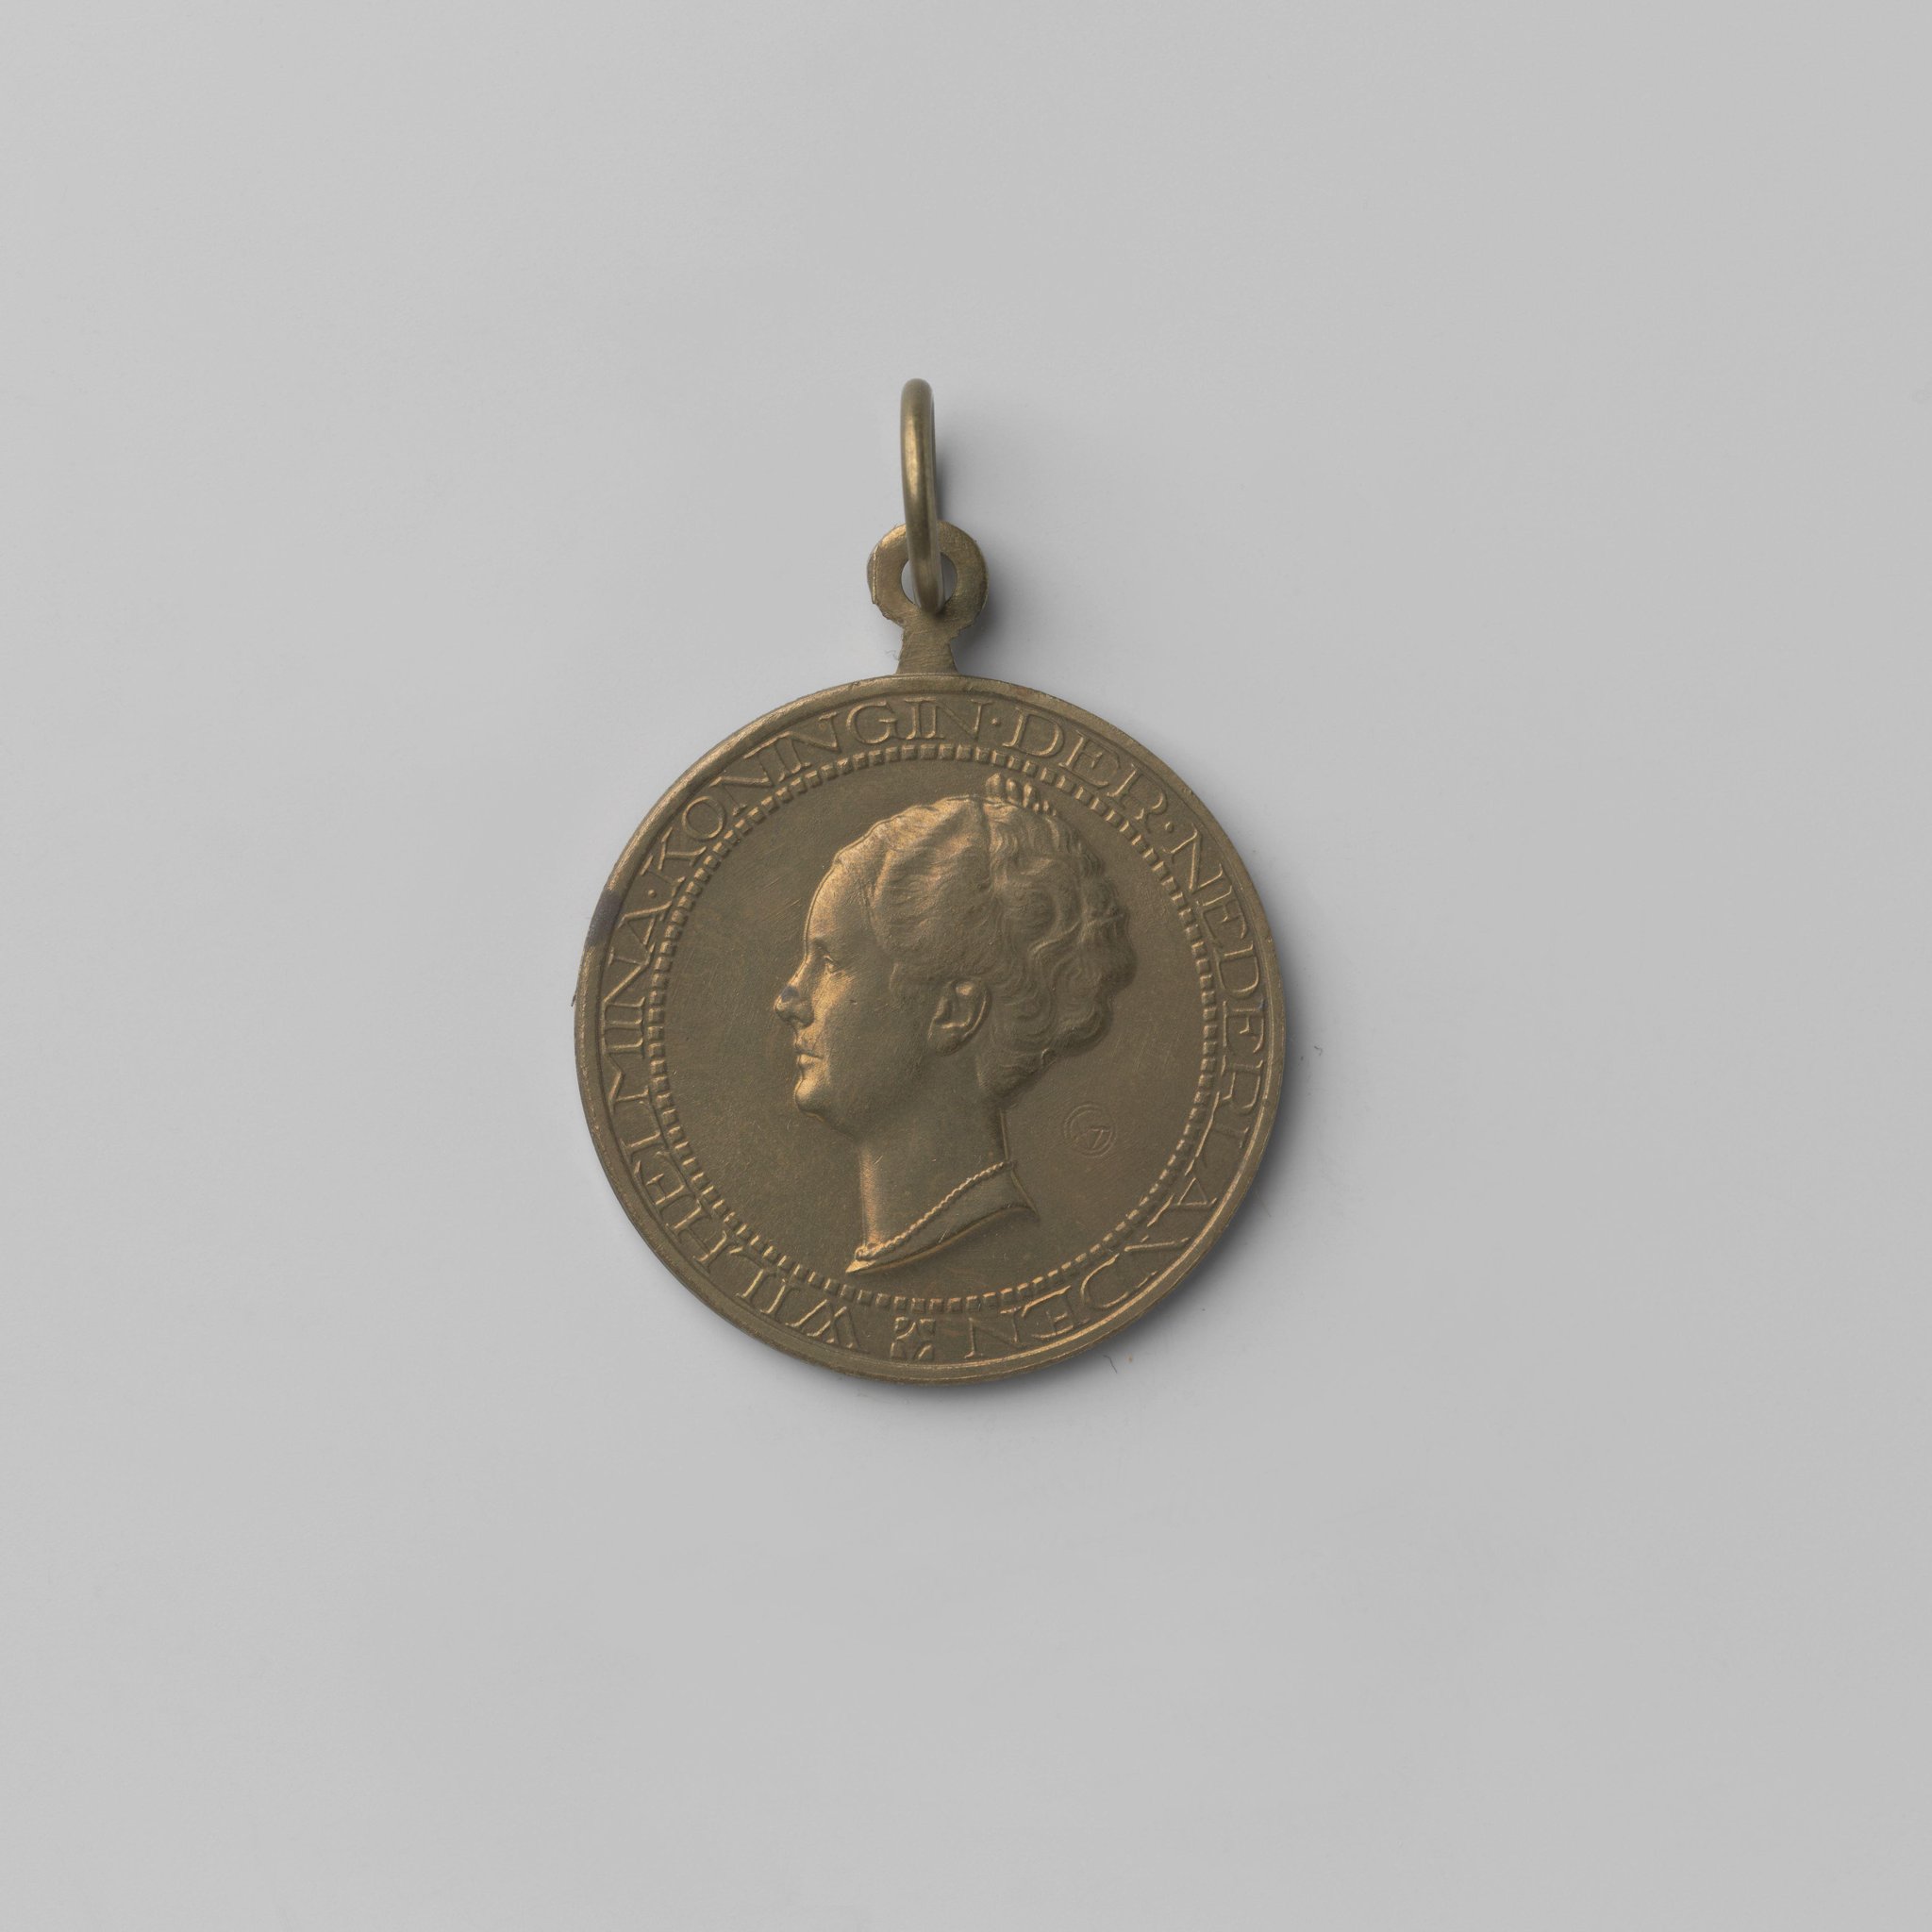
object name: history medal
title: Vijftigste verjaardag van Koningin Wilhelmina 1930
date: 1930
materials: brass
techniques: striking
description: Messing penning met oog en draagring, op de voorzijde het portret van Wilhelmina naar links met omschrift, op de keerzijde het gekroonde Nederlandse rijkswapen tussen twee jaartallen.